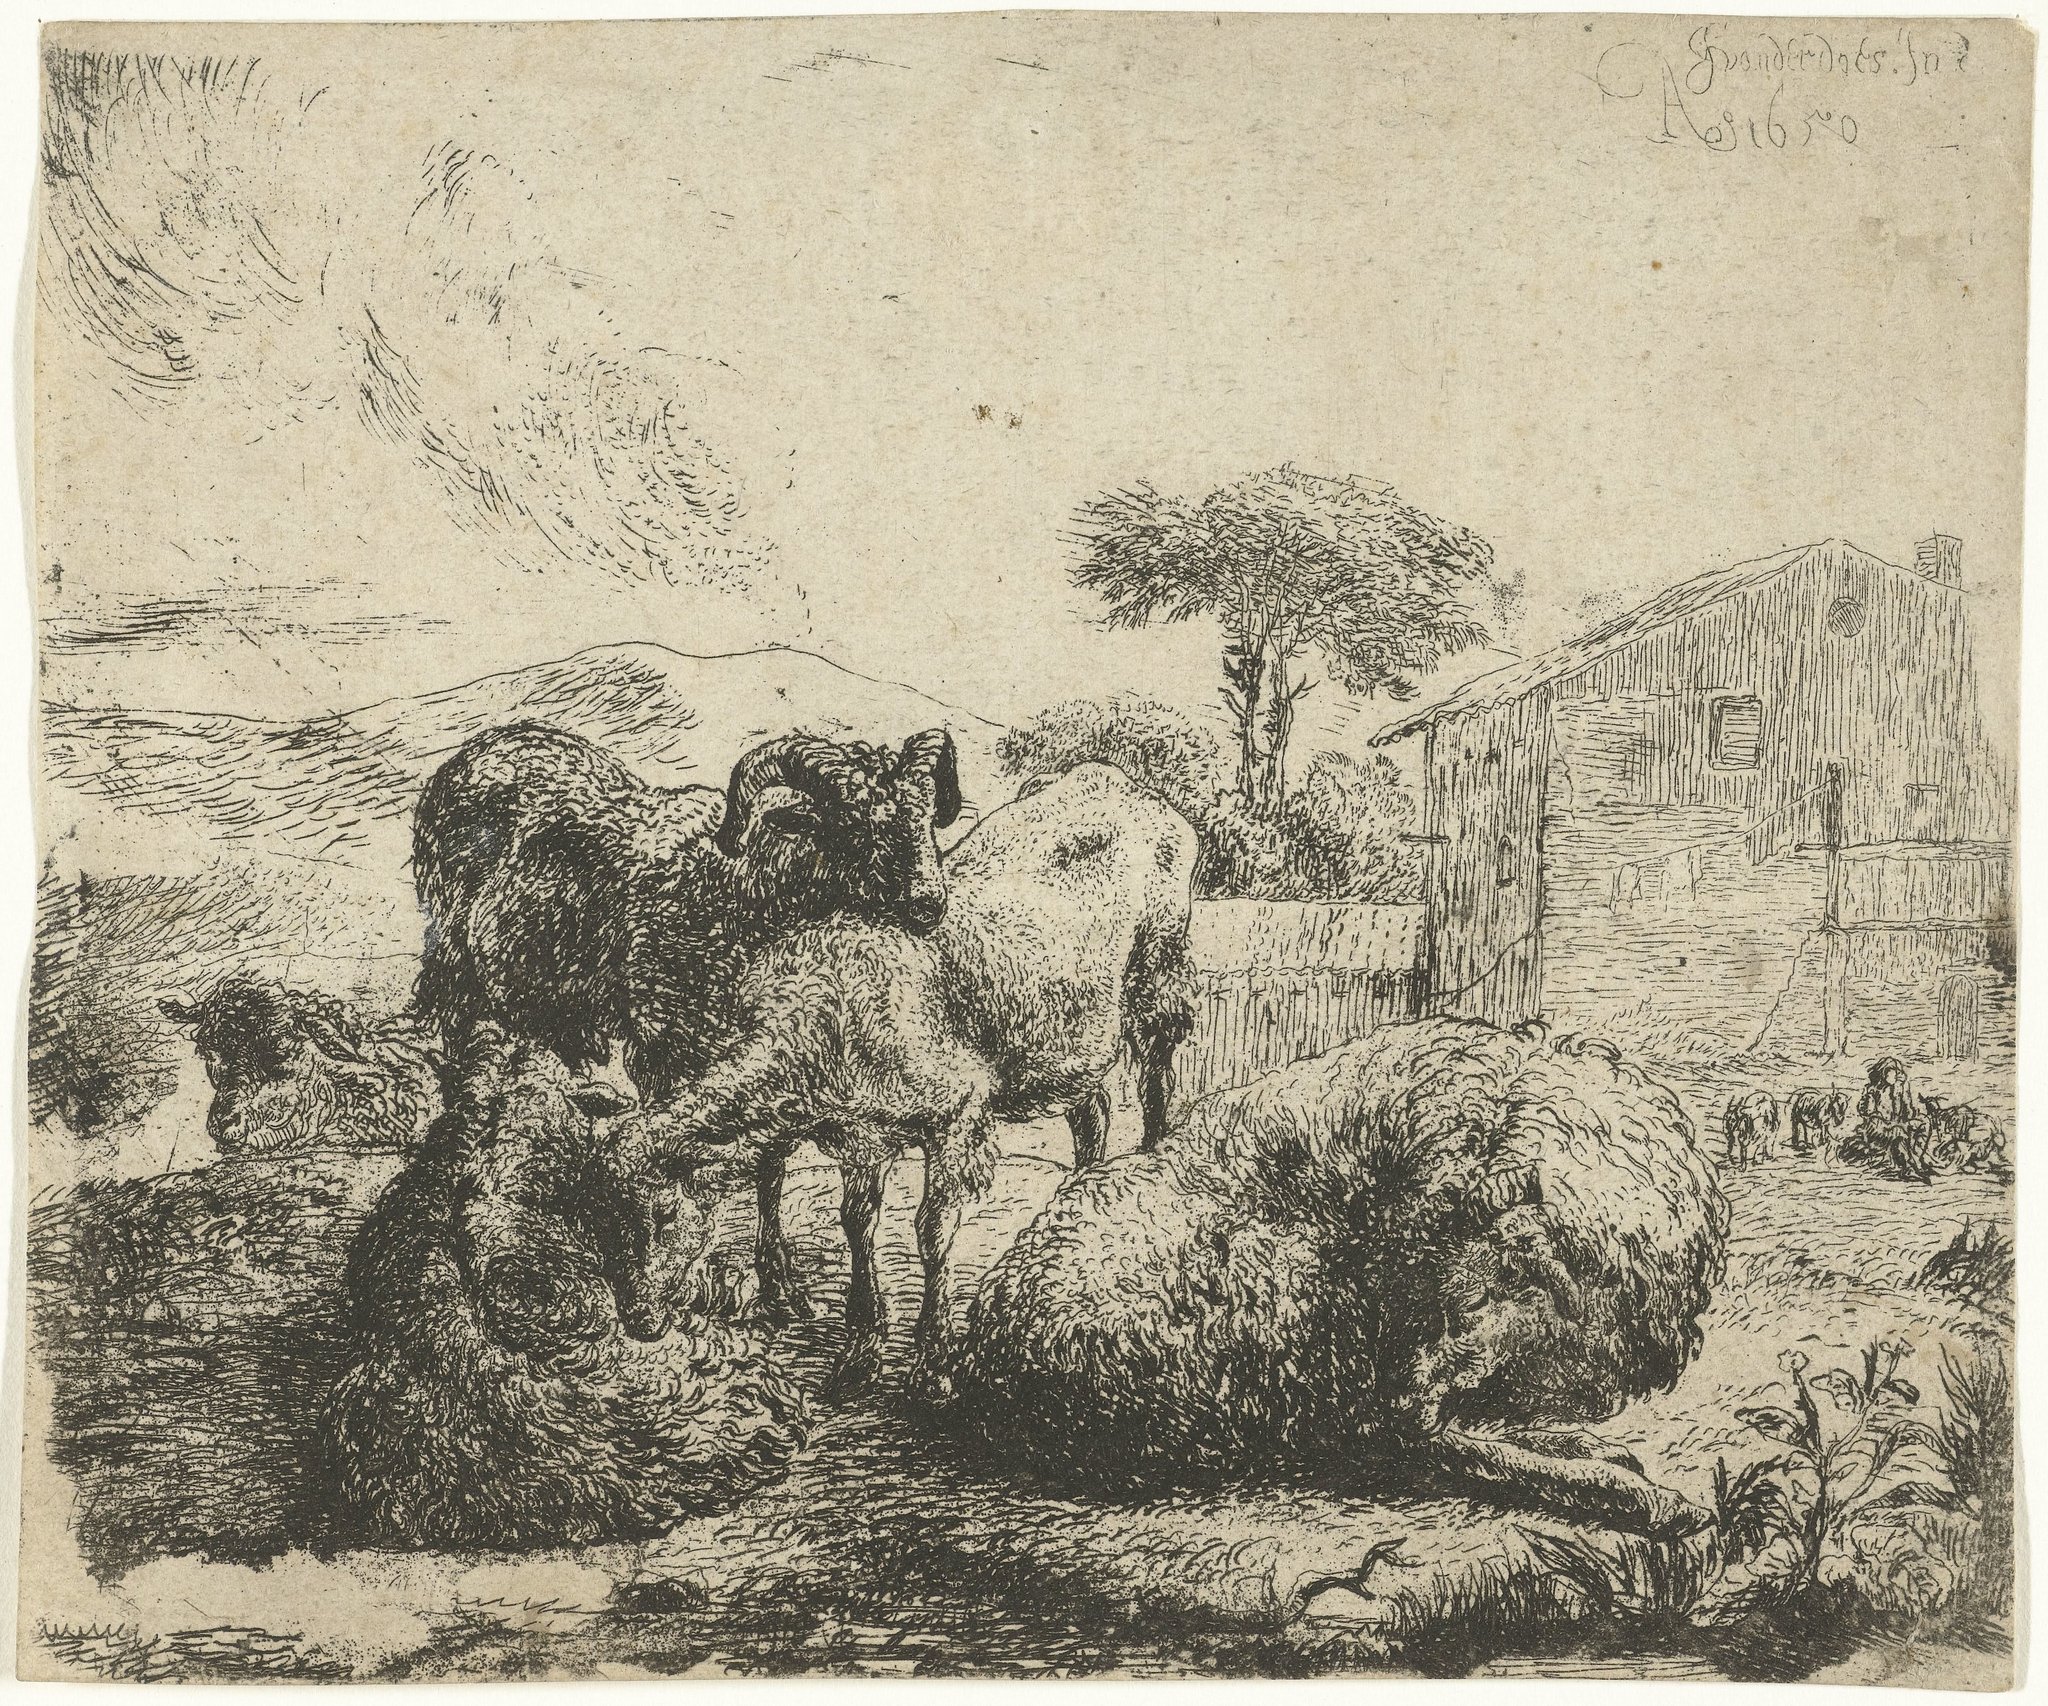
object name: print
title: Groep van vijf schapen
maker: jacob van der does (i)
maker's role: draughtsman, painter, print maker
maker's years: 1623-1673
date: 1650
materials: paper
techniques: etching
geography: netherlands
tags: sheep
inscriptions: collector's mark: Lugt 240